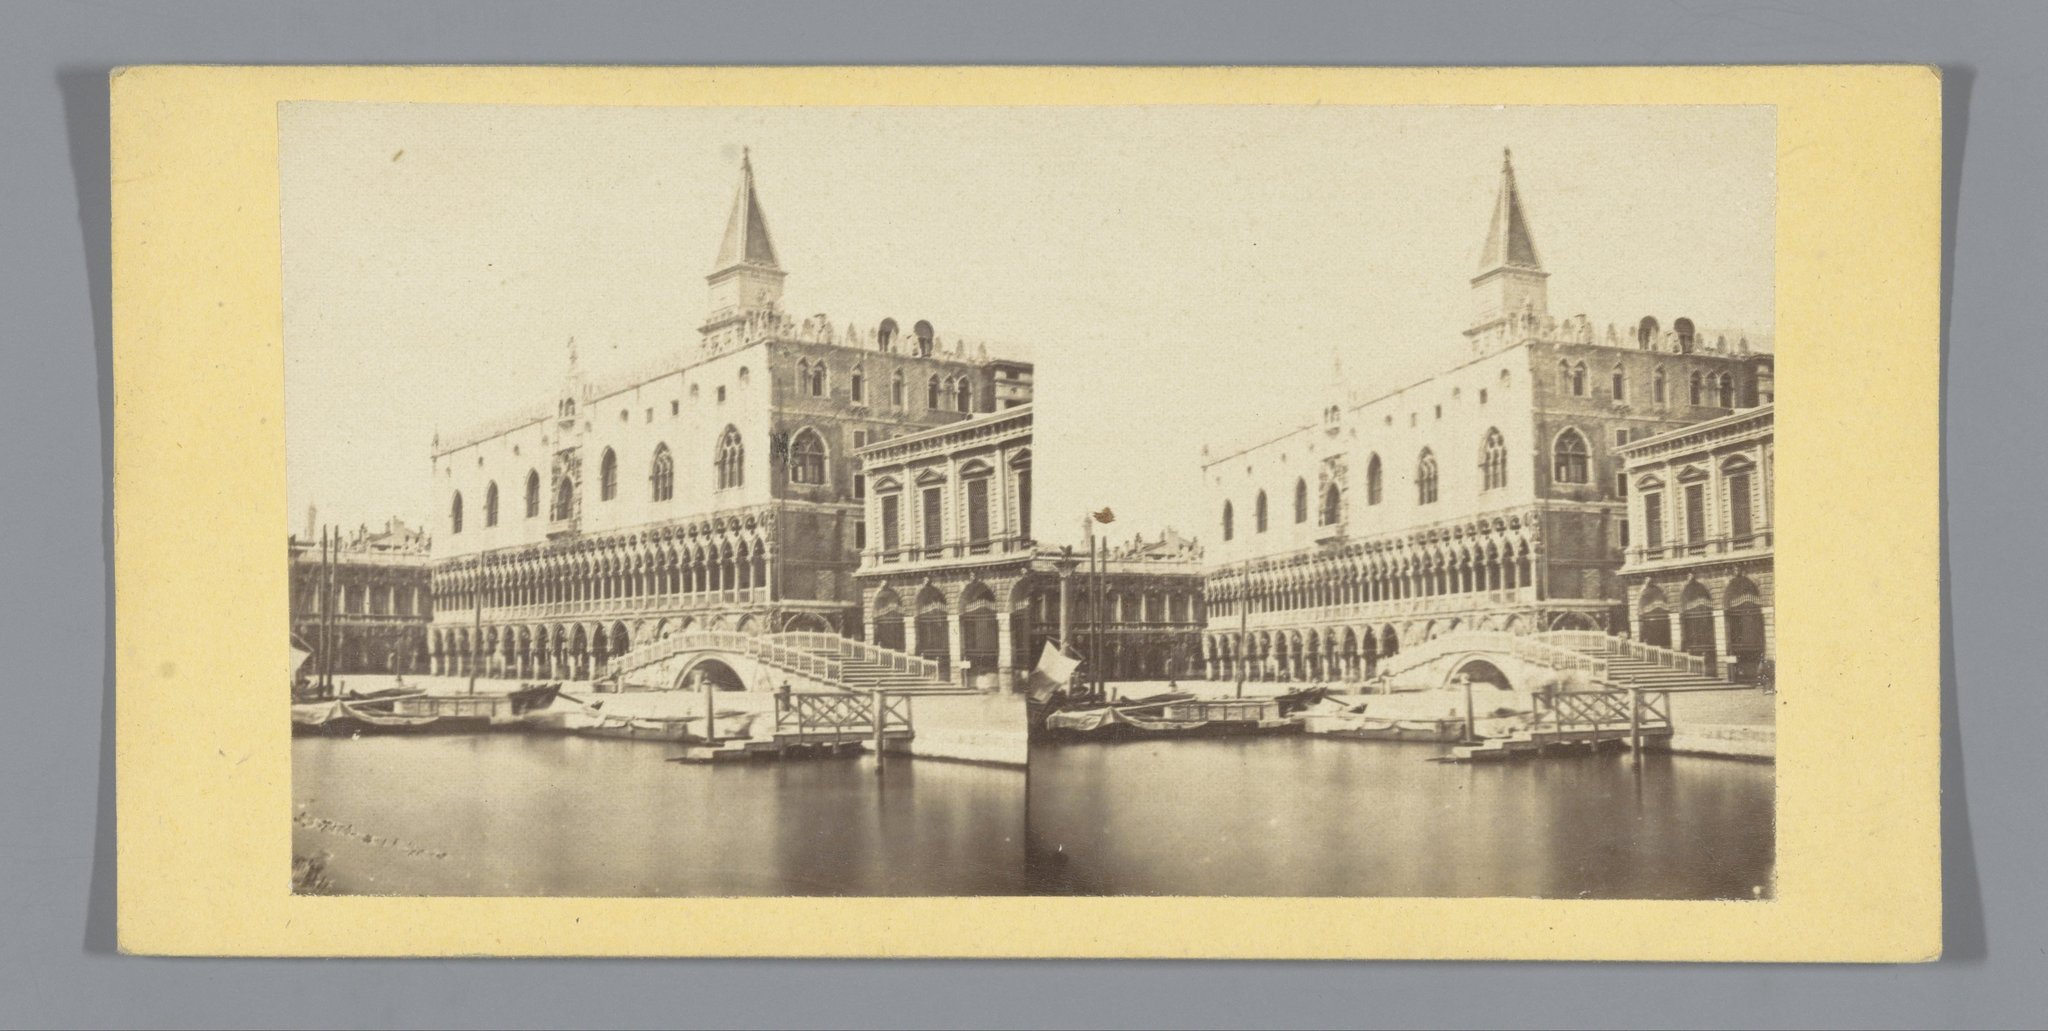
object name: stereograph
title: Achtergevel van het Dogenpaleis te Venetië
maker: Anonymous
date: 1850-1880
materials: cardboard, photographic support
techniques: albumen print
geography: venice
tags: palace, façade (of house or building)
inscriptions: inscription: ‘Palazzo Ducale verso il Molo Venezia’